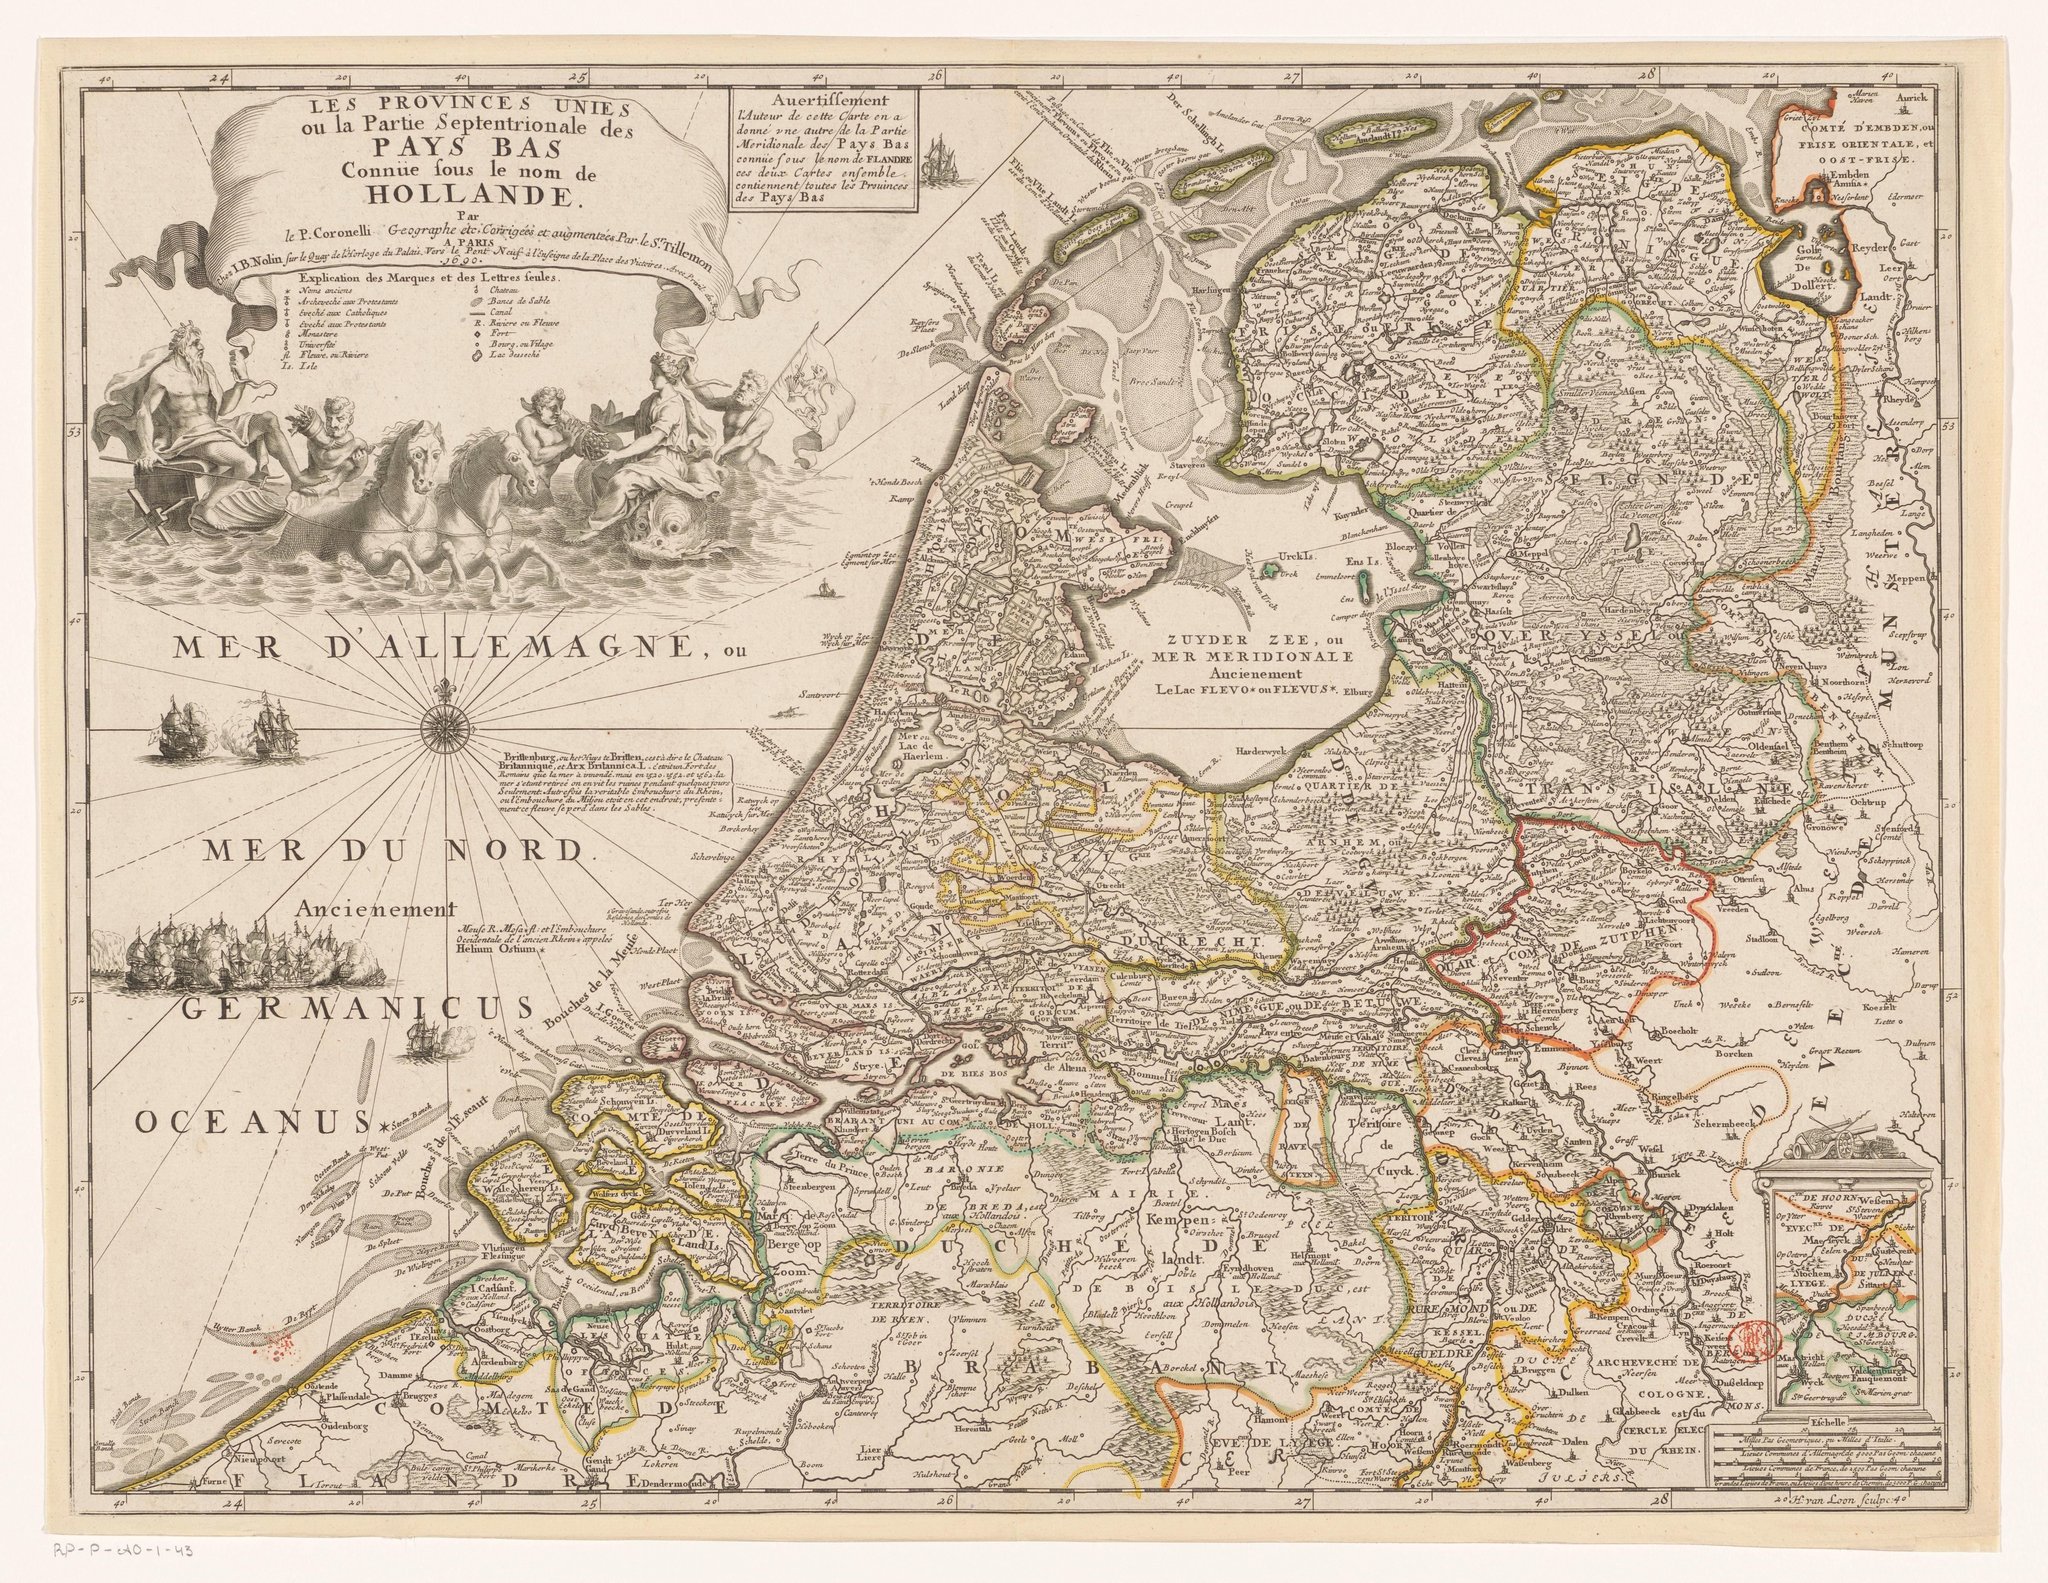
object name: map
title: Les Provinces Unies ou la partie septentrionale des Pays Bas connue sous le nom de Hollande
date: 1690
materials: paper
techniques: engraving, hand coloring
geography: paris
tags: (story of) neptune (poseidon), triton(s), maps of separate countries or regions, other female roman deities: salacia, netherlands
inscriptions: collector's mark: Lugt 2228, collector's mark: Lugt 195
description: Franse kaart van de Republiek. Linksboven cartouche met titel, daaronder een legenda en een mythologische voorstelling met Neptunus, een vrouwfiguur (mogelijk Salacia) en drie tritons. Naast titelcartouche een cartouche met advertentie voor een kaart van de Zuidelijke Nederlanden van dezelfde uitgever. Rechtsonder cartouche met een inzet van een deel van het huidige Limburg (deel dat destijds tot Staats-Brabant behoorde). Daaronder schaalstok: Milles pas geometriques ou milles d'Italie, Lieües communes d'Allemagne de 4000 pas geom: chacune en Grandes lieües de France, ou lieües d'une heure de chemin de 3000 P.G. chacune. Gradenverdeling langs de randen.